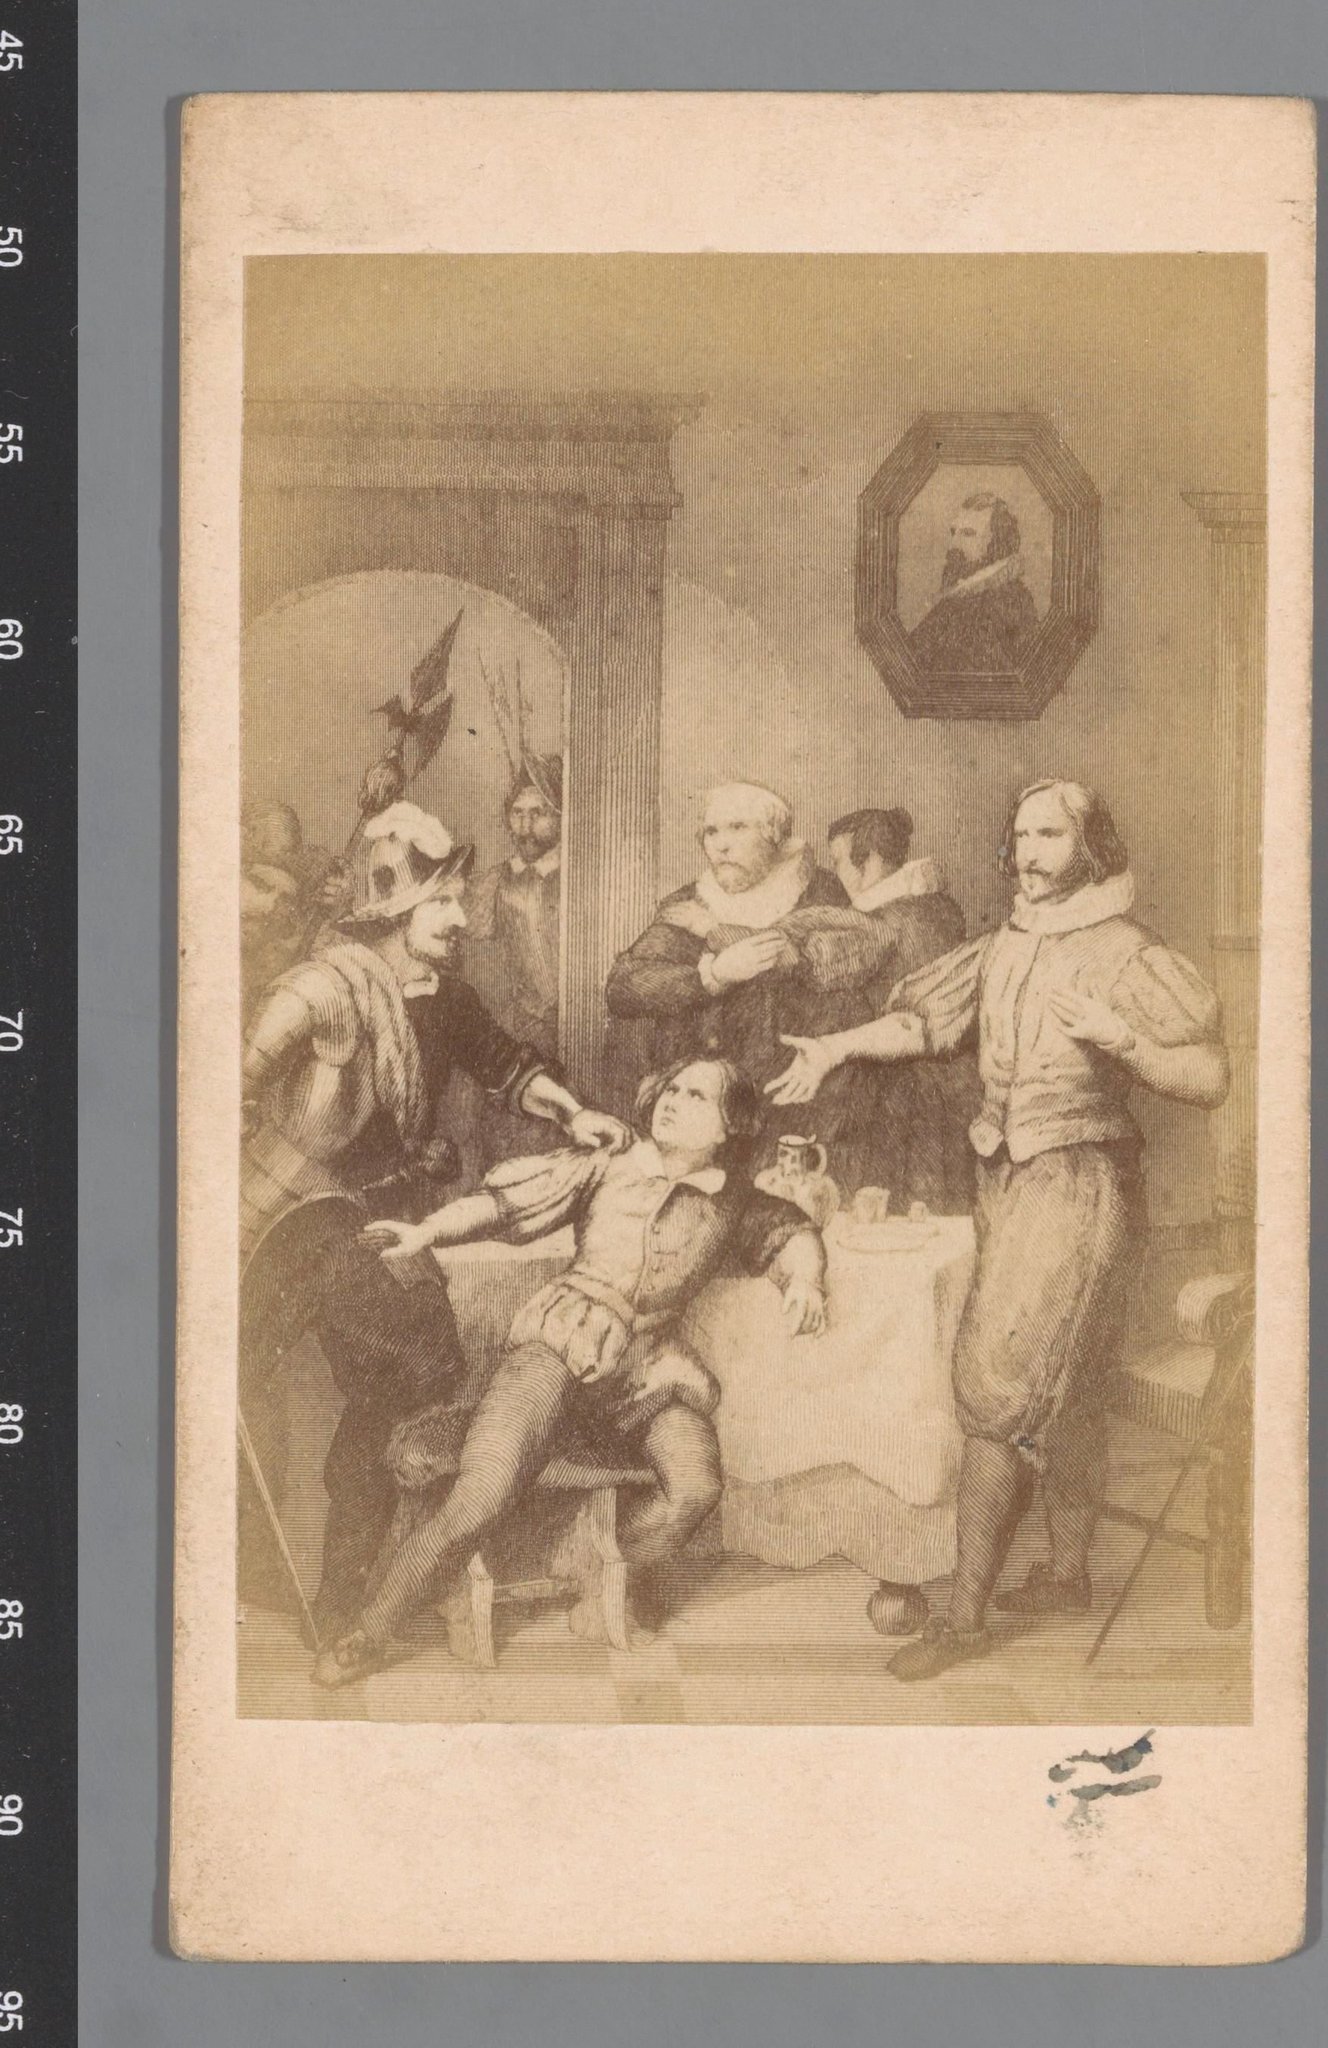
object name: carte de visite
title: Fotoreproductie van een gravure van Pieter Dirksz. Hasselaar tijdens het Beleg van Haarlem in 1572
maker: Anonymous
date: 1850-1900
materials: cardboard, paper, photographic support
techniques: albumen print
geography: netherlands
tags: haarlem, amsterdam, arrest (of criminal)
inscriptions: inscription: ‘Het Beleg (...) gewichtige ambten.’, number: ‘19’, number: ‘20’